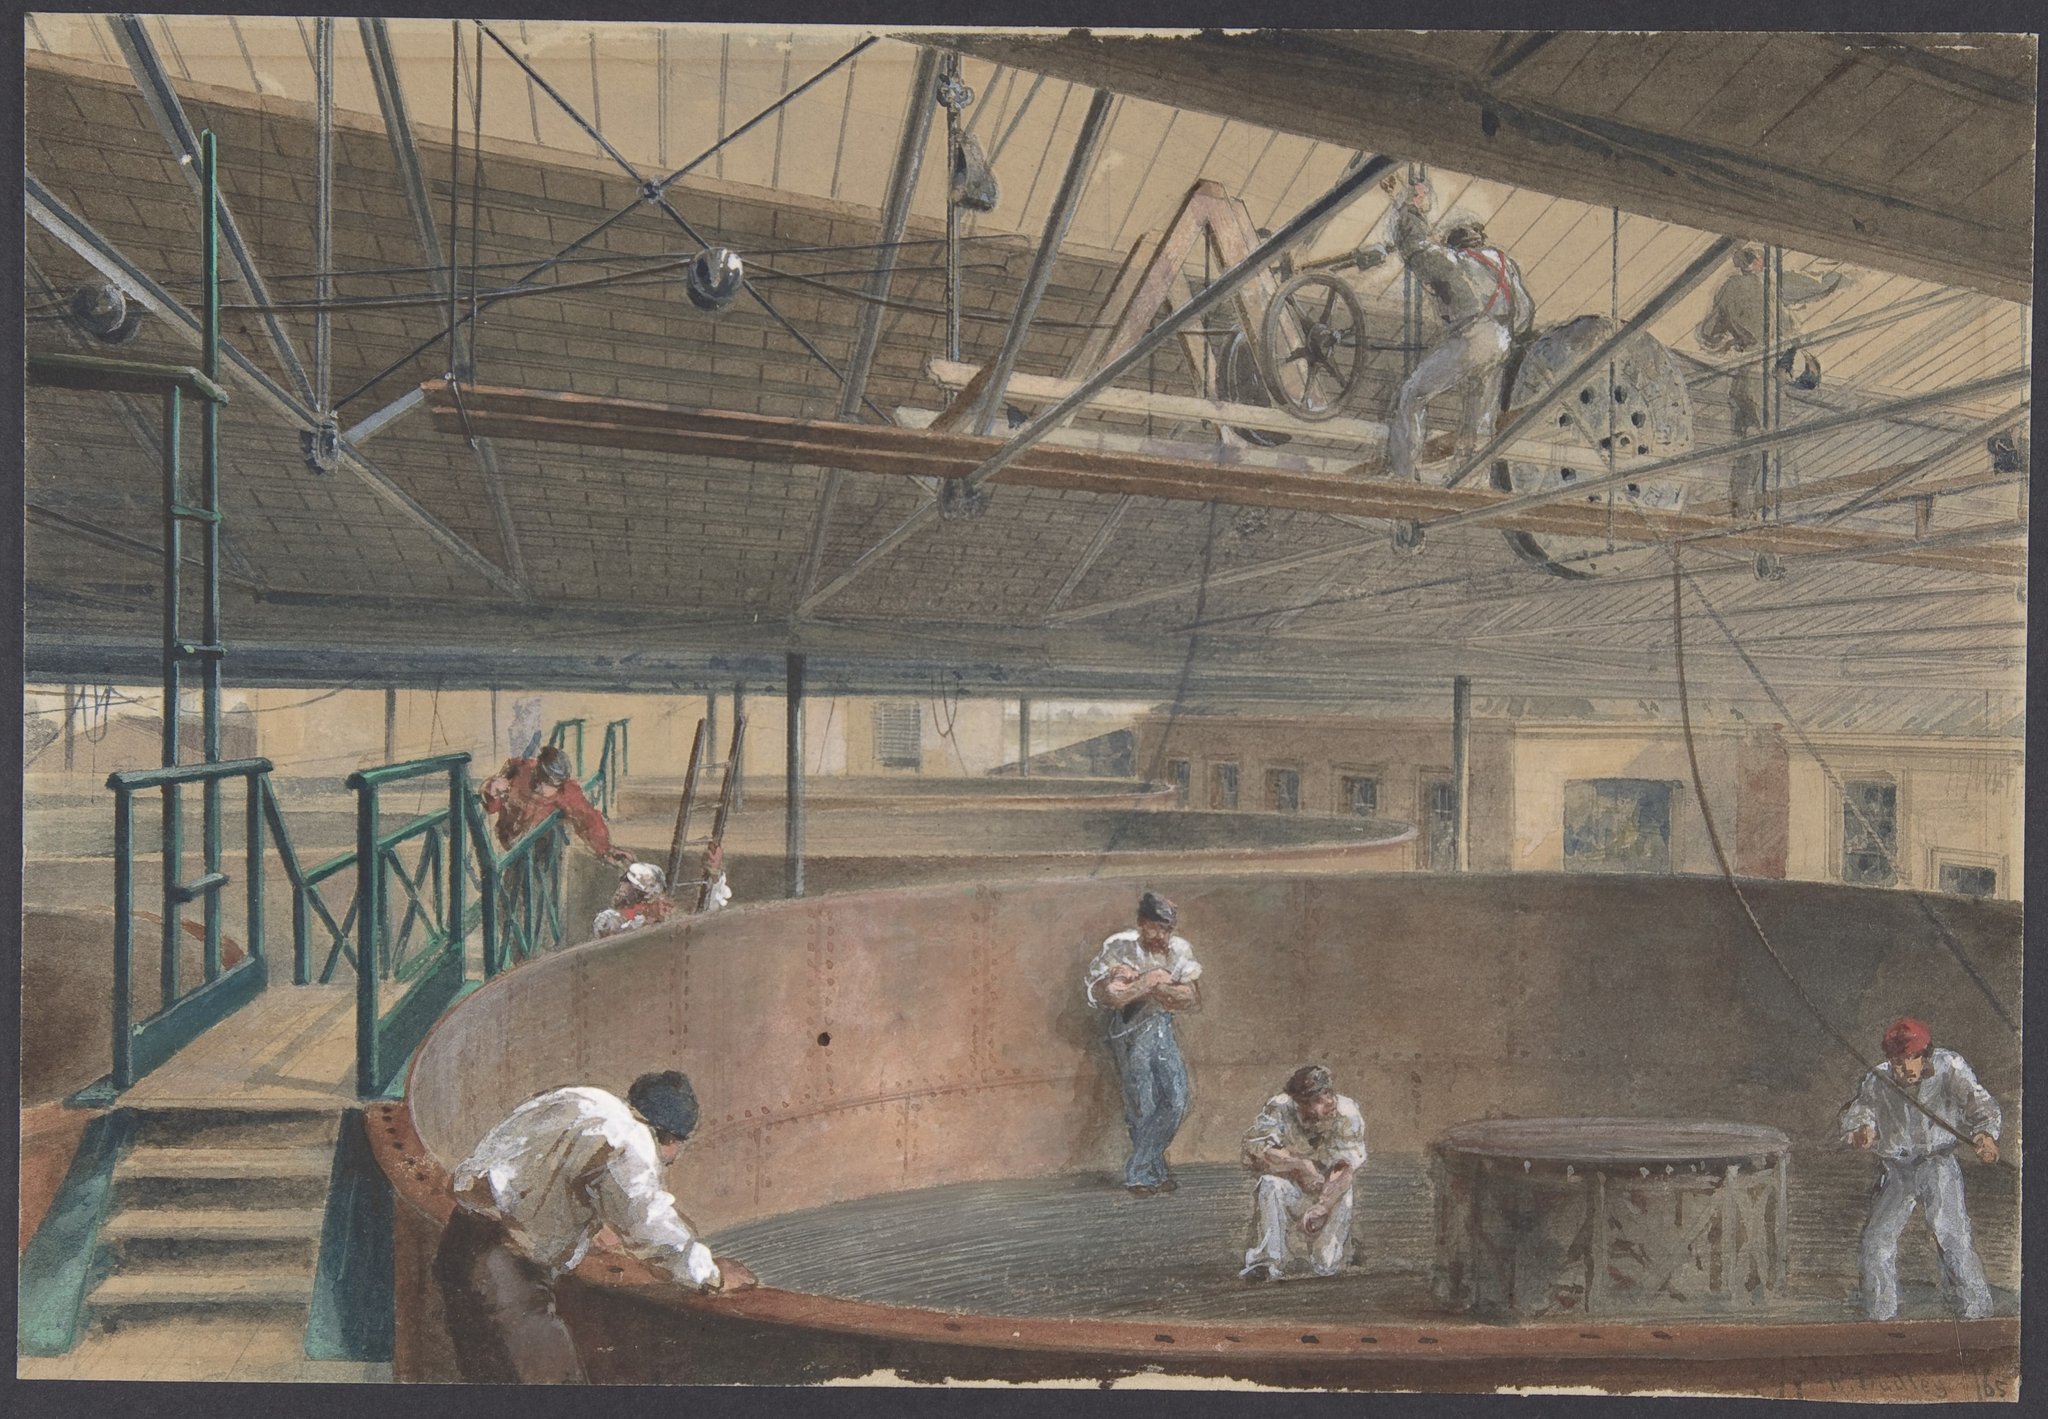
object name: drawing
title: Coiling the Cable in the Large Tanks at the Works of the Telegraph Construction and Maintenance Company of Greenwich, 1865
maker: robert charles dudley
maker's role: artist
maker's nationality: british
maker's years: 1826-1909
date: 1865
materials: gouache, graphite, watercolor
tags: men,working,machines,transatlantic cable